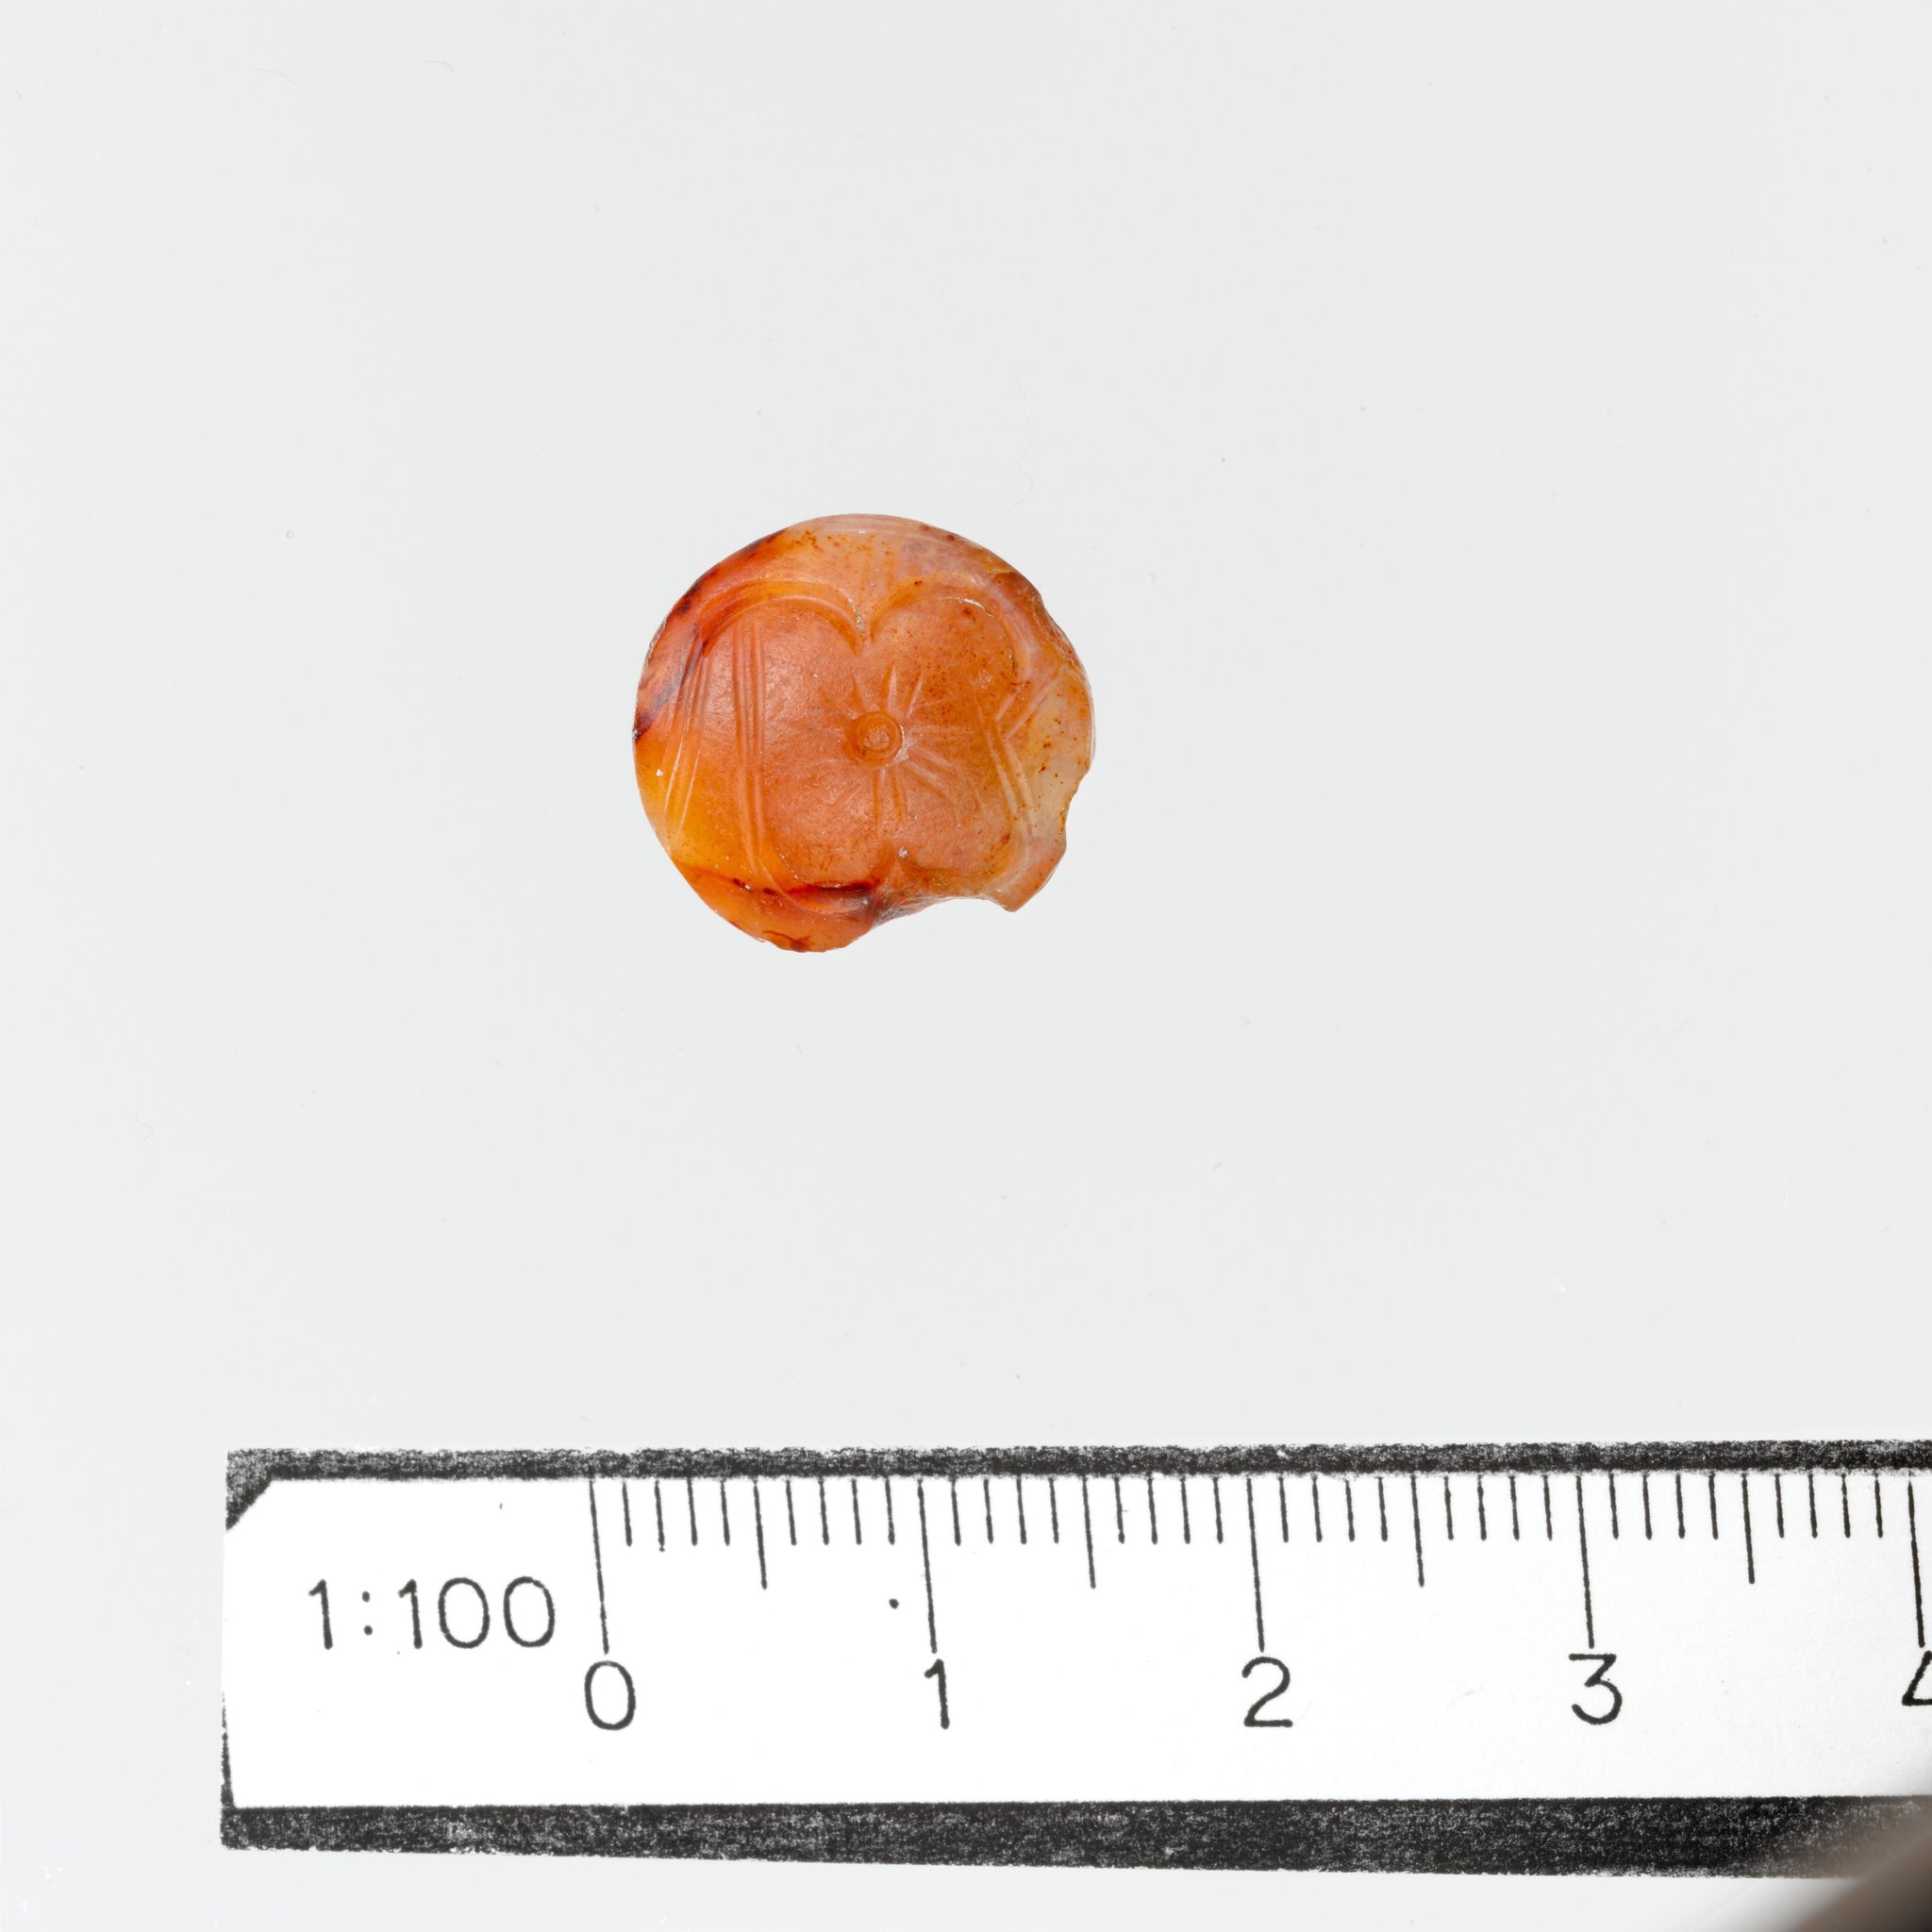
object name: seal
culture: minoan, crete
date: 2000-1450 BCE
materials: stone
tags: flowers